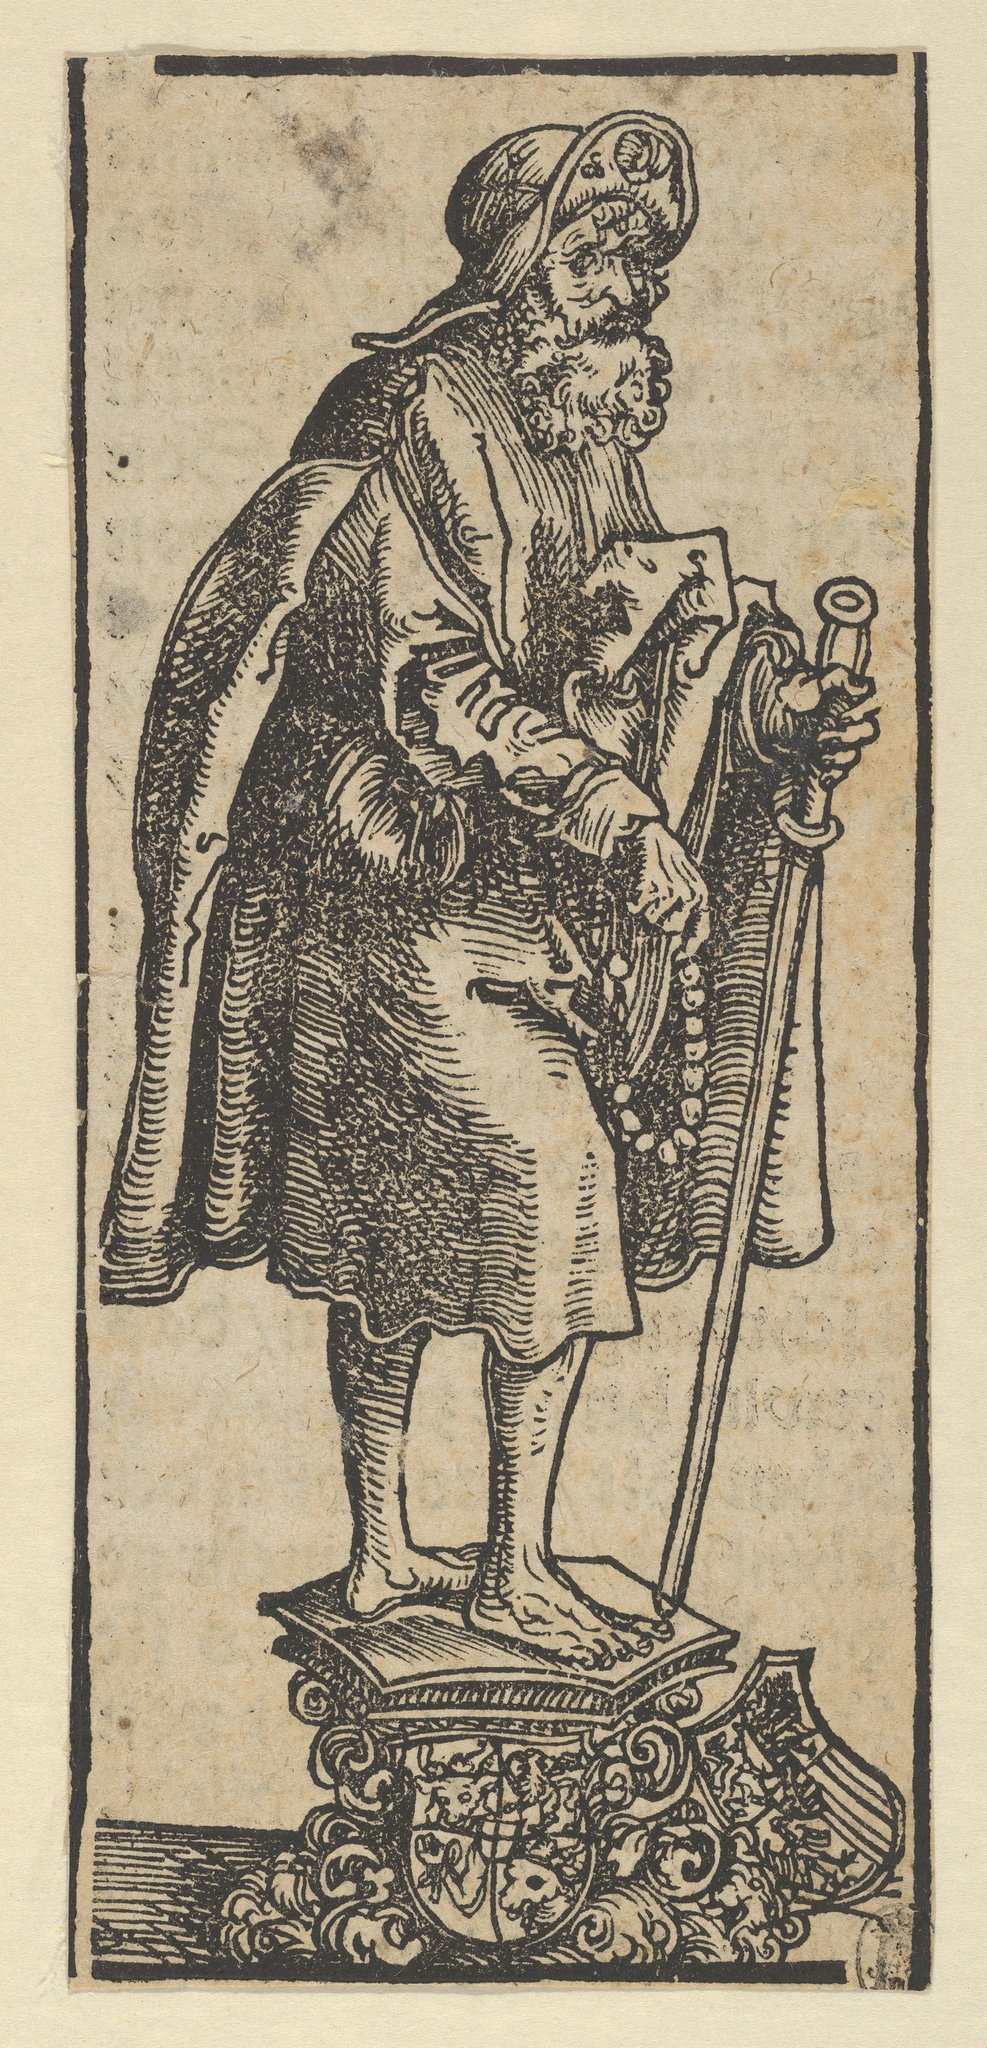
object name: print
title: Silver Statuette of St. James the Greater, from the "Wittenberg Reliquaries"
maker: lucas cranach the elder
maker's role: artist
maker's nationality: german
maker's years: 1472-1553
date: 1472-1553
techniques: woodcut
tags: saints